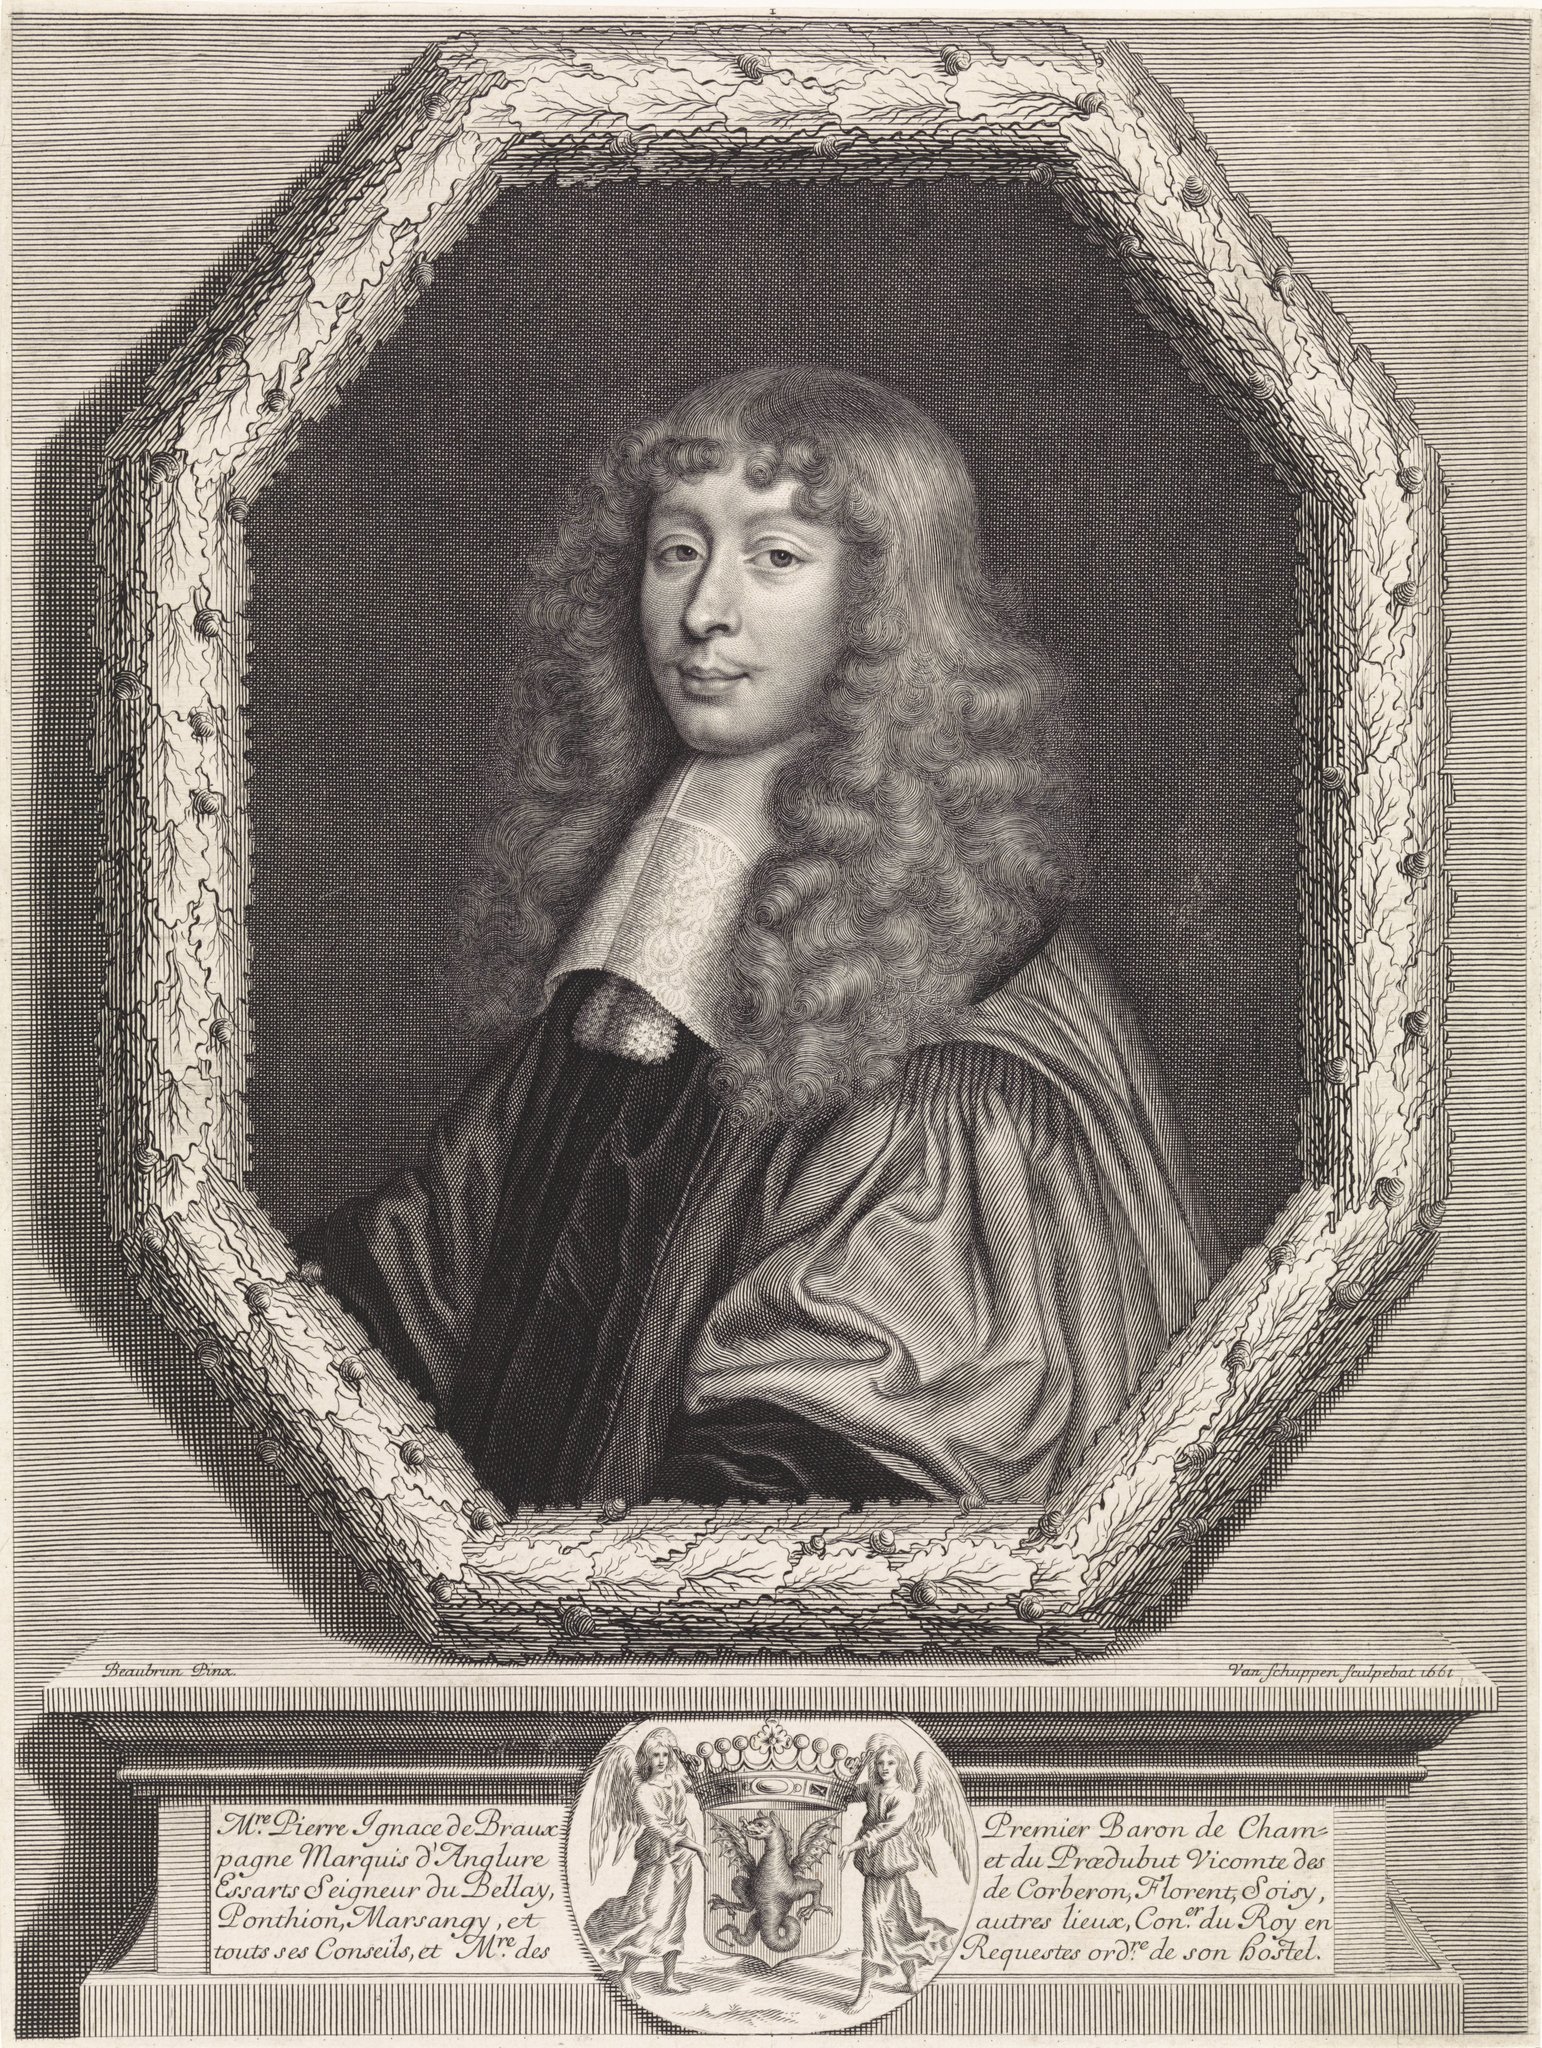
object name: print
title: Portret van Pierre Ignace de Braux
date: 1661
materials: paper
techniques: engraving, etching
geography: paris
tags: pierre ignace de braux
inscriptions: collector's mark: Lugt 2228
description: Portret van Pierre Ignace de Braux, eerste baron van Champagne, in een omlijsting van eikels en eikenbladeren. Op het piëdestal zijn gekroonde wapenschild, dat vastgehouden wordt door twee engelen. Aan weerszijden van het wapenschild vijf regels tekst in het Frans, waarin zijn naam en titels opgesomd worden.